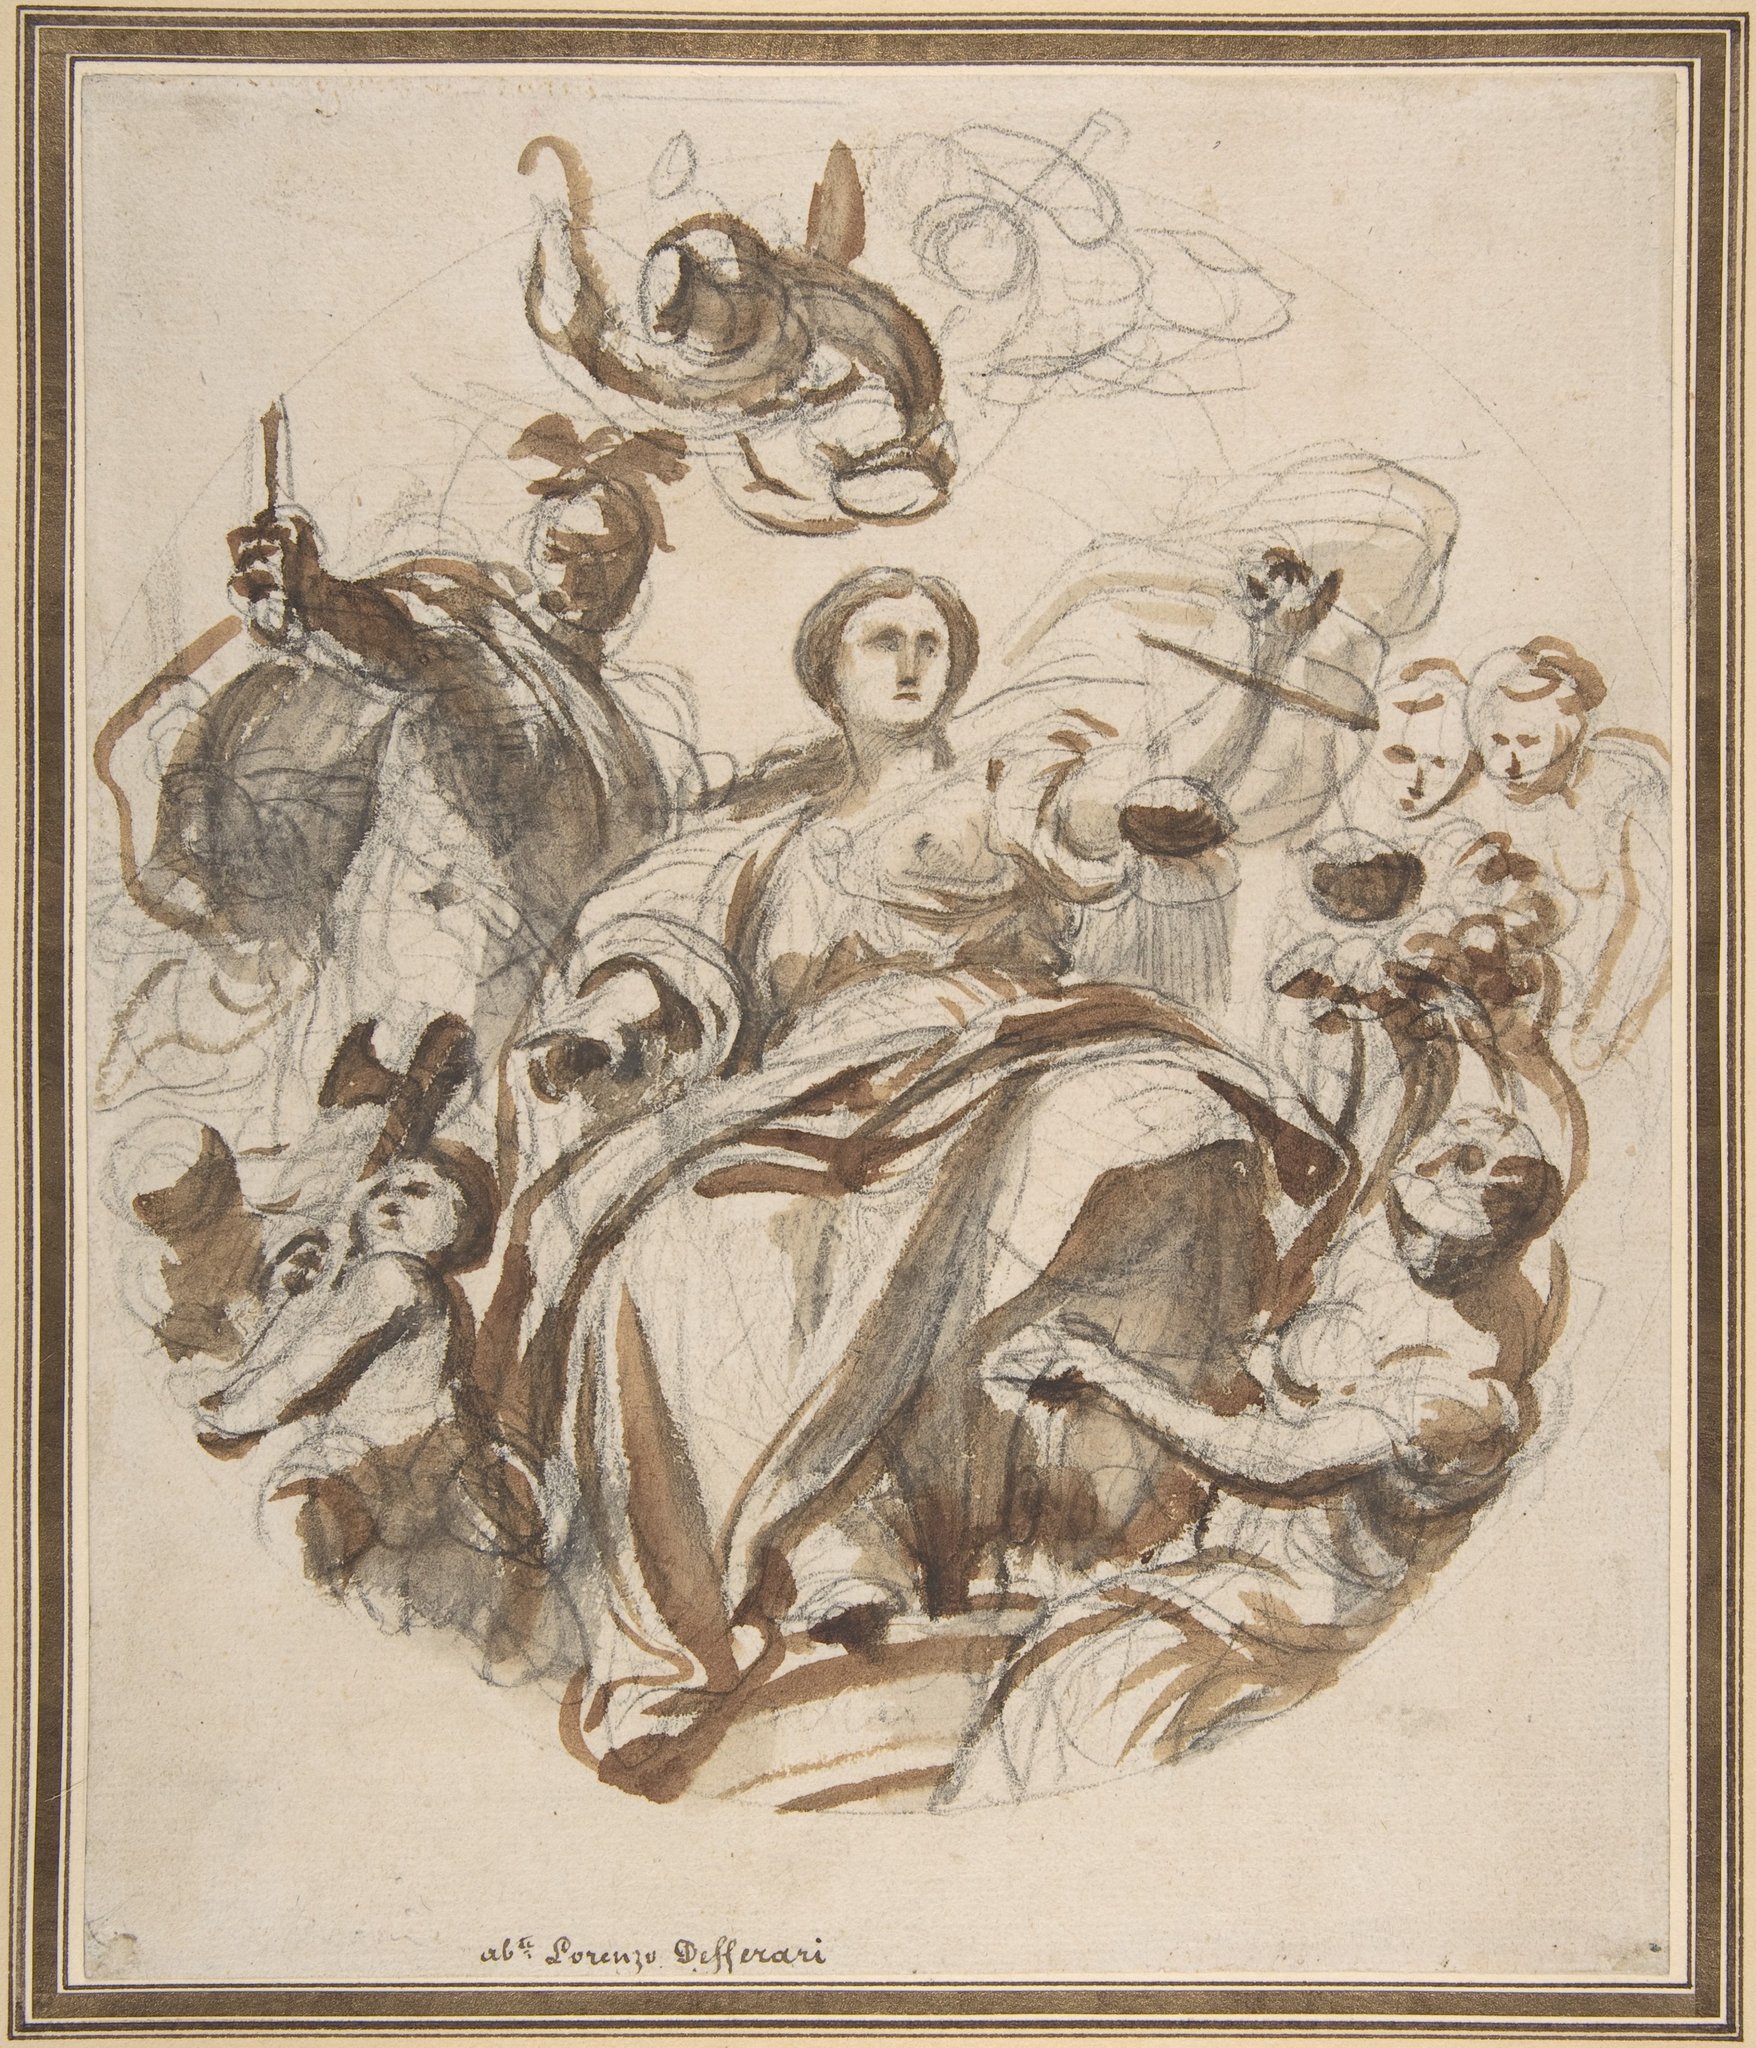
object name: drawing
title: Study of Justice Dispensing Rewards to the Arts (recto); Study of a Lunette and Spandrel (verso)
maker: lorenzo de' ferrari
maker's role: artist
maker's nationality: italian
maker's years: 1680-1744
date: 1680-1744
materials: chalk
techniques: brush, wash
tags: men,women